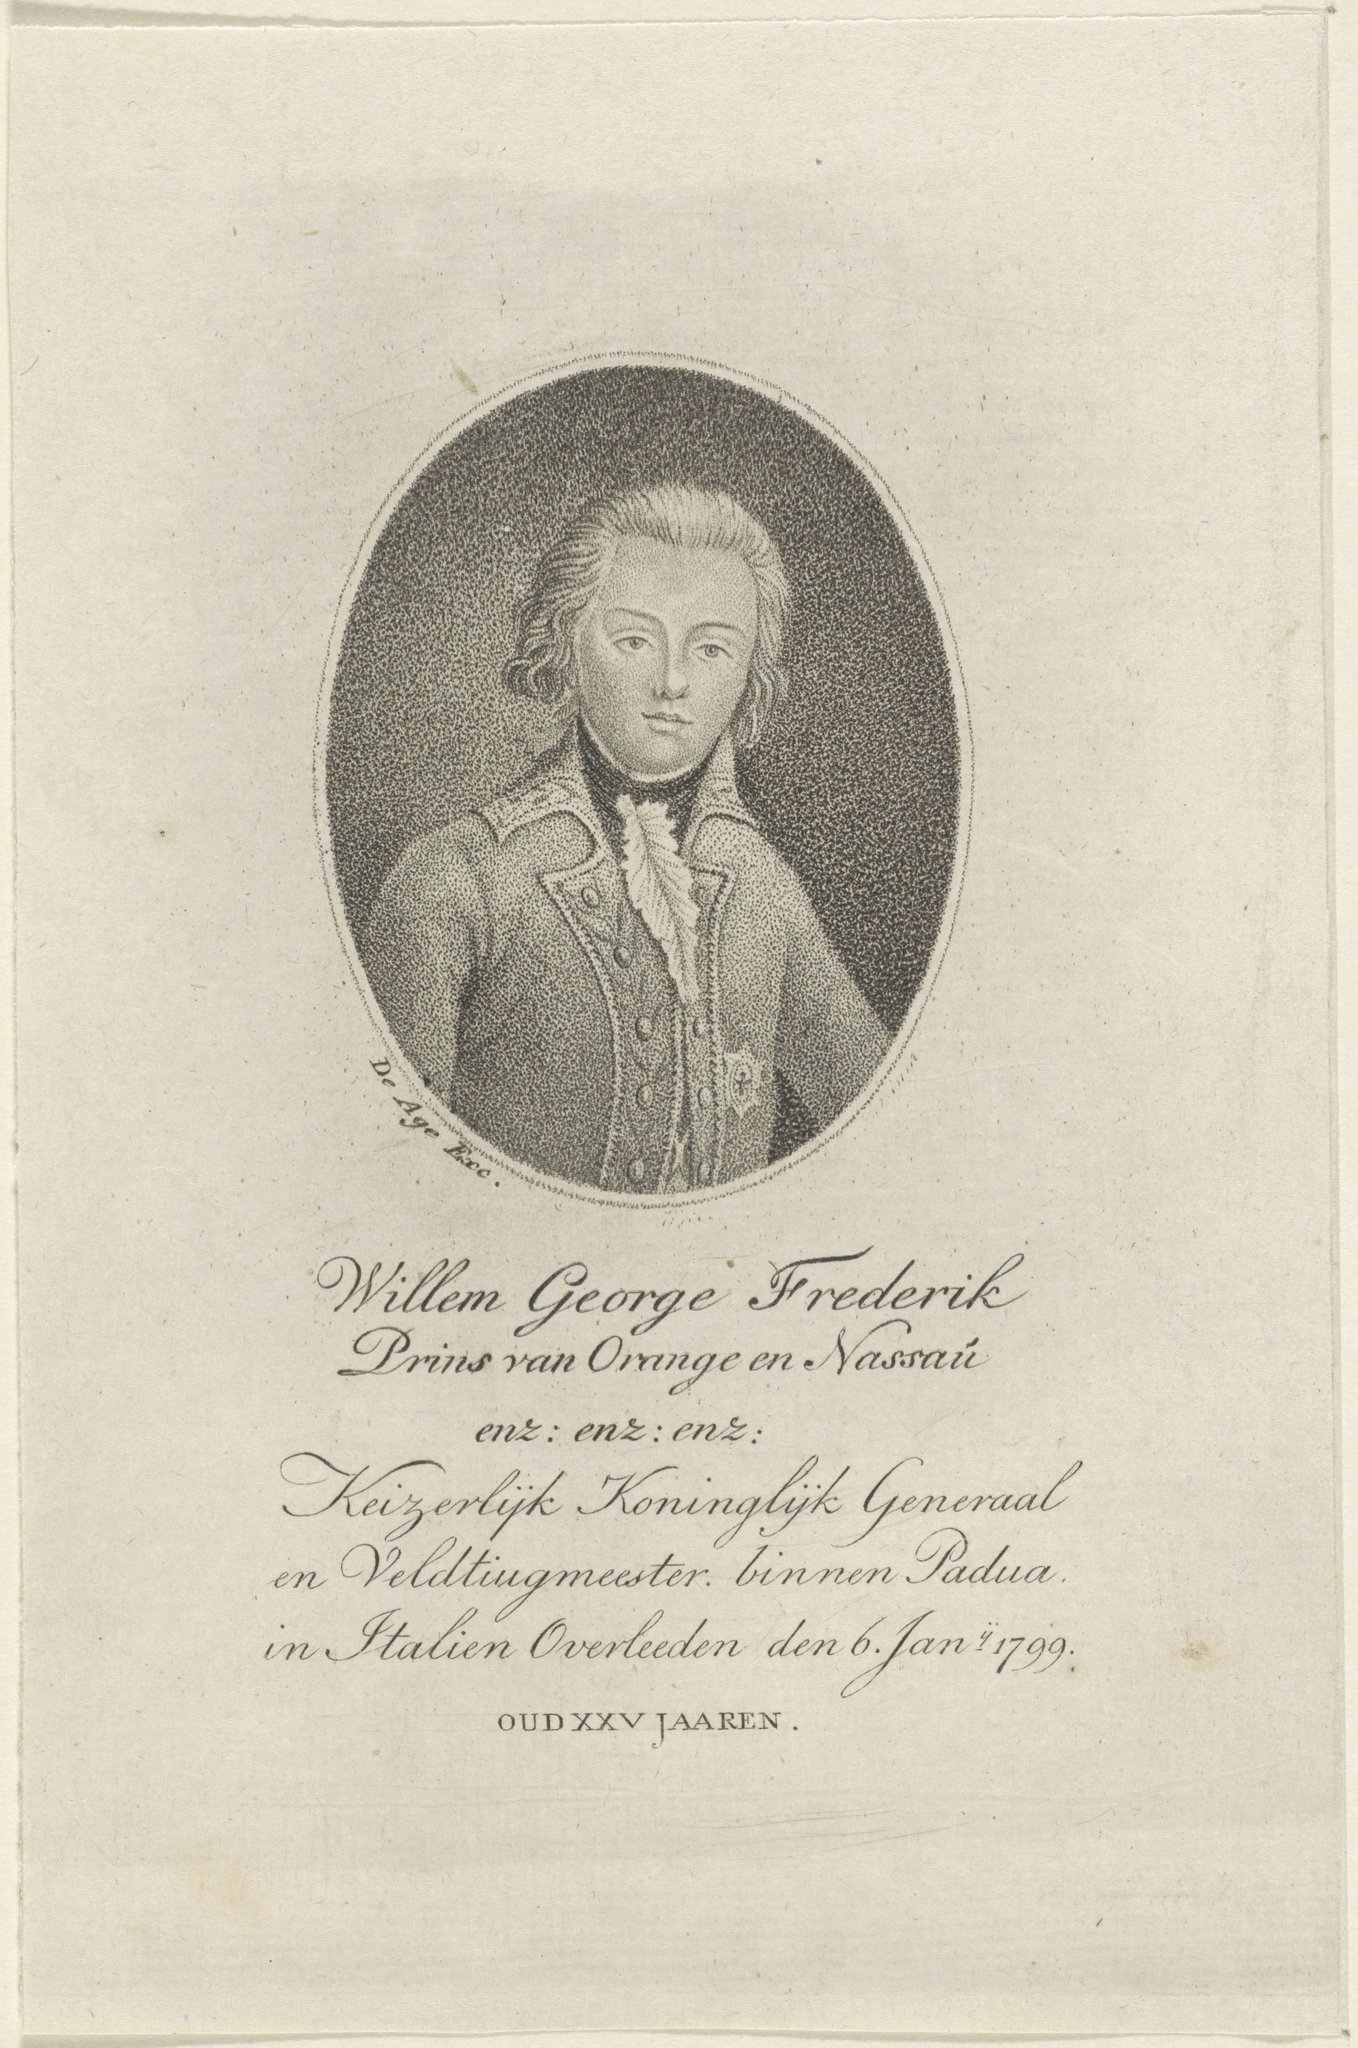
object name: print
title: Portret van Frederik, prins van Oranje-Nassau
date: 1799-1801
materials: paper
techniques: engraving, etching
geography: the hague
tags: the hague, willem george frederik (prins van oranje-nassau), knighthood order (with name) - insignia of a knighthood order, e.g.: badge, chain (with name of order)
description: De hier vermelde titel verwijst naar de hoogst verkregen titel van de geportretteerde, niet per se naar de titel die de geportretteerde op deze voorstelling draagt.